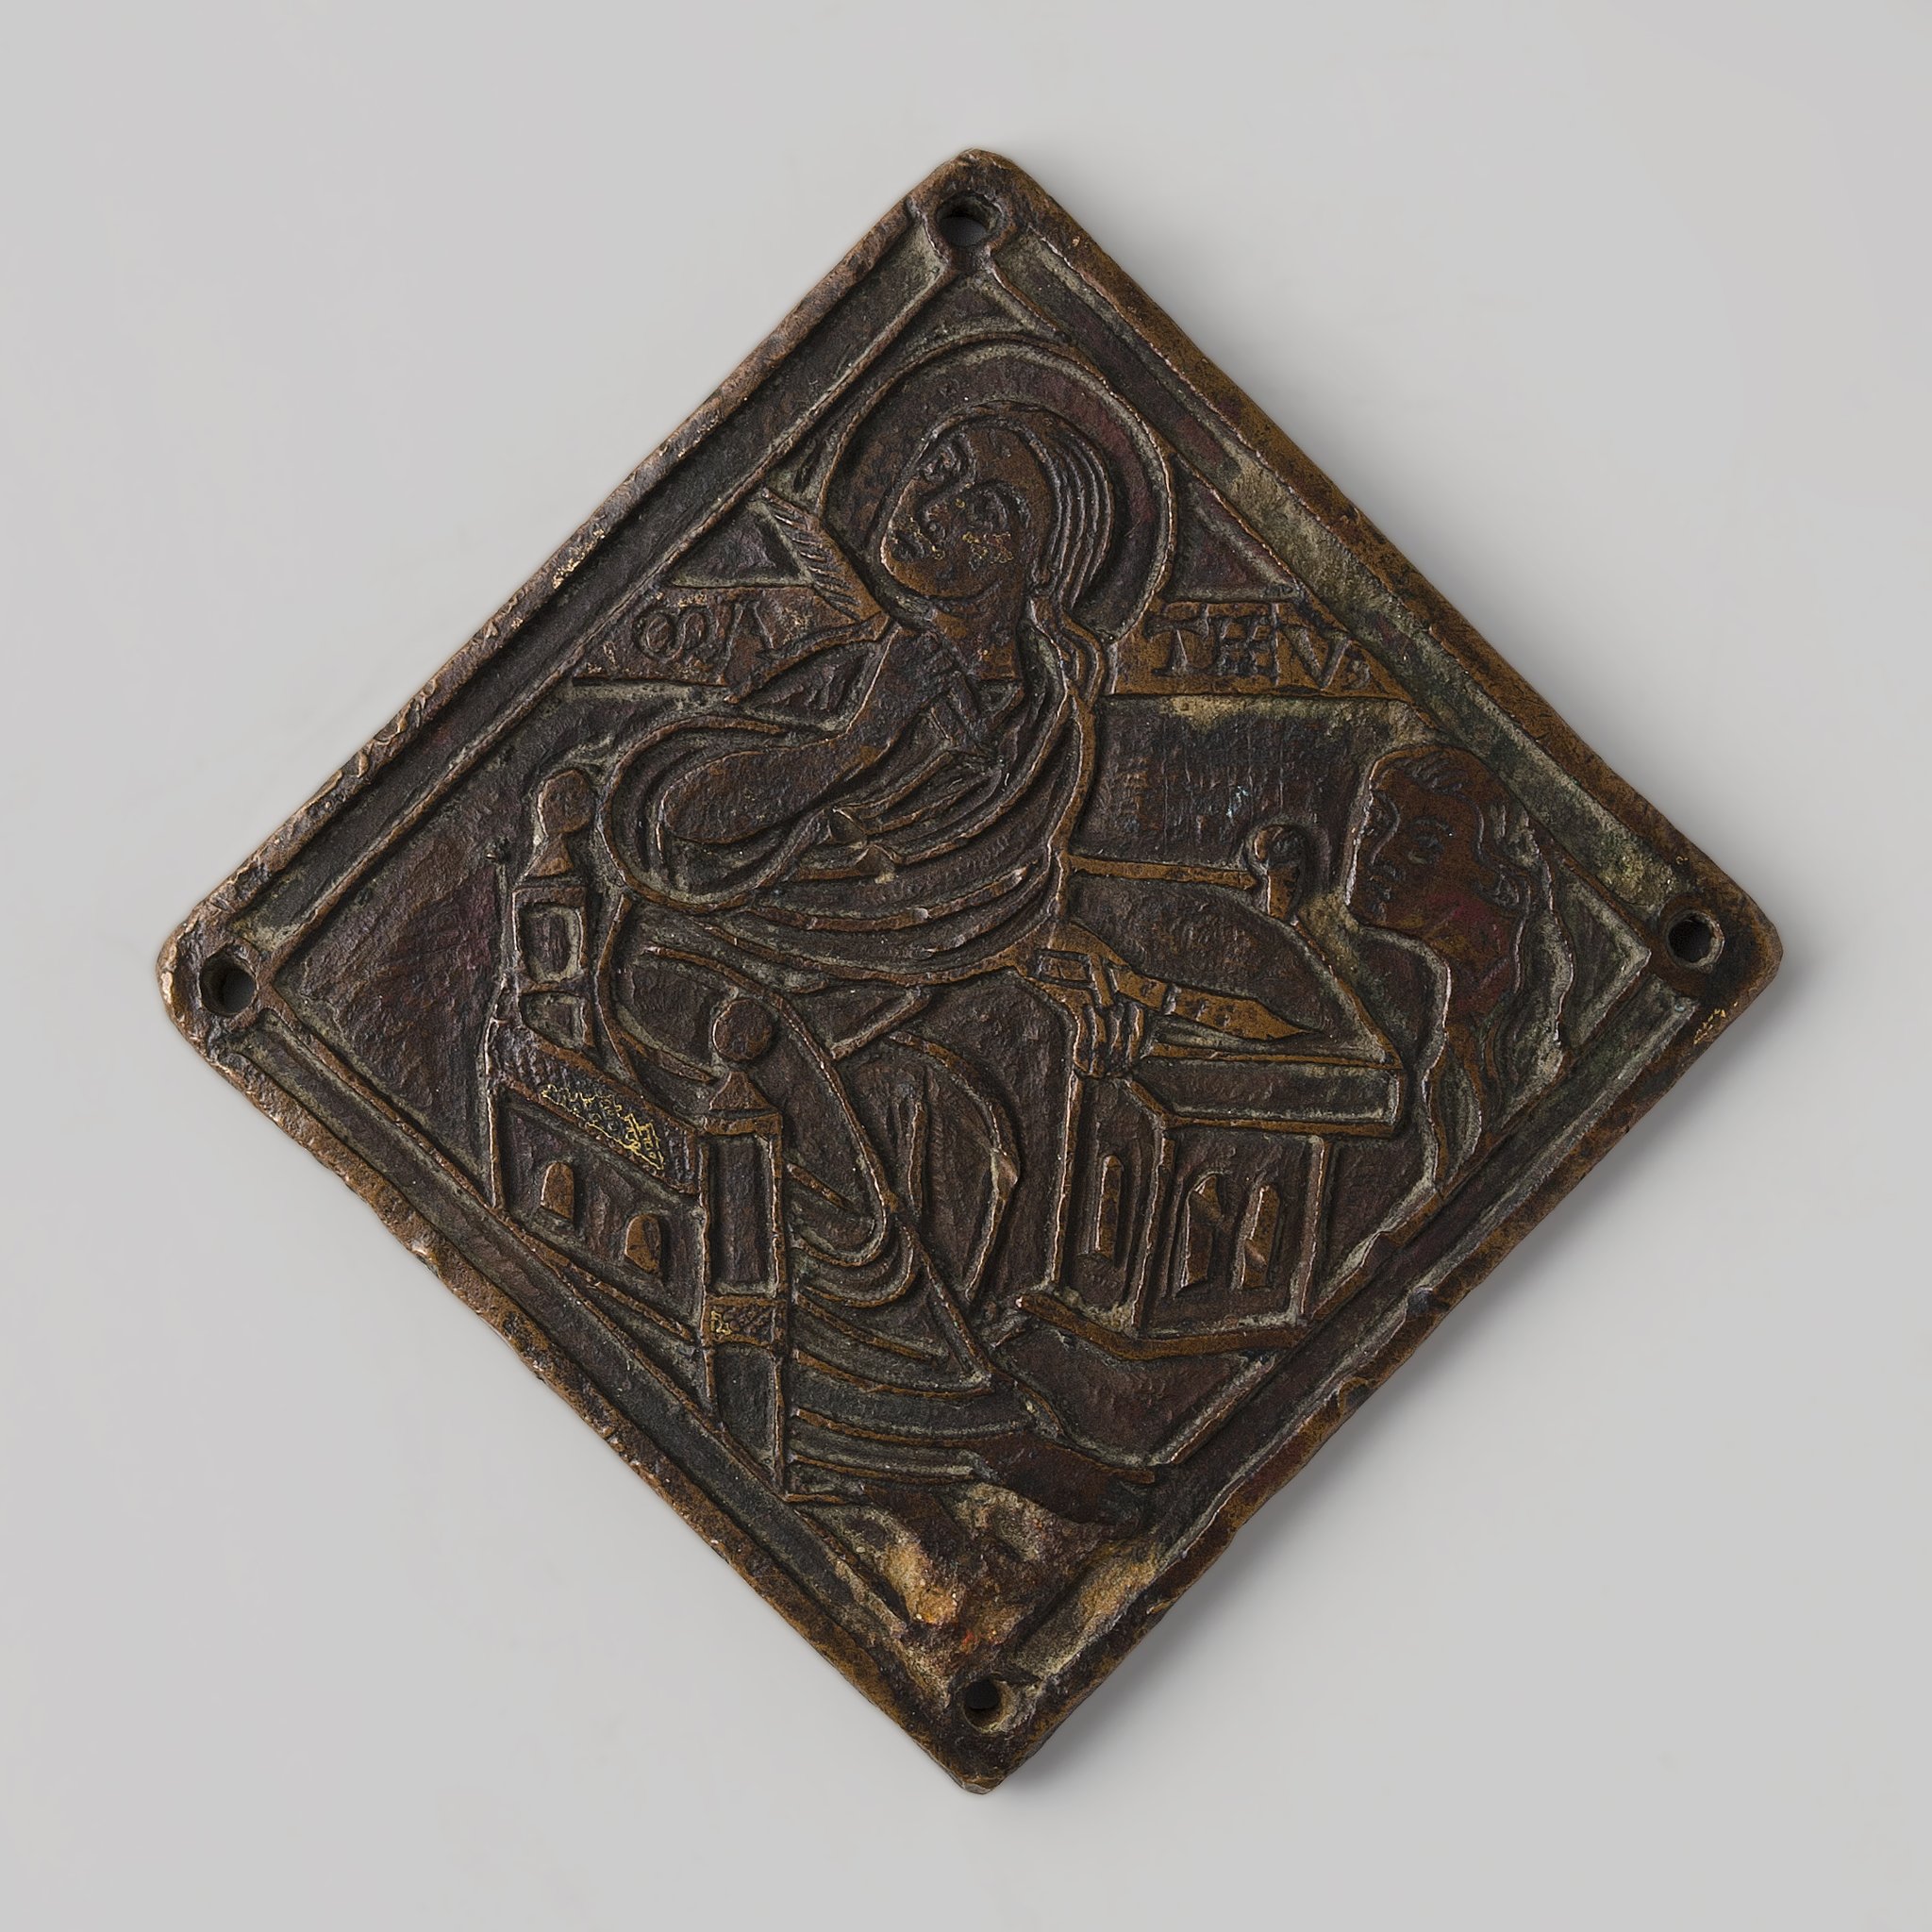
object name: plaque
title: Saint Matthew Writing the Gospel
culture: mosan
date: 1155-1165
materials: copper alloy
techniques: gilding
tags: saint matthew,writing